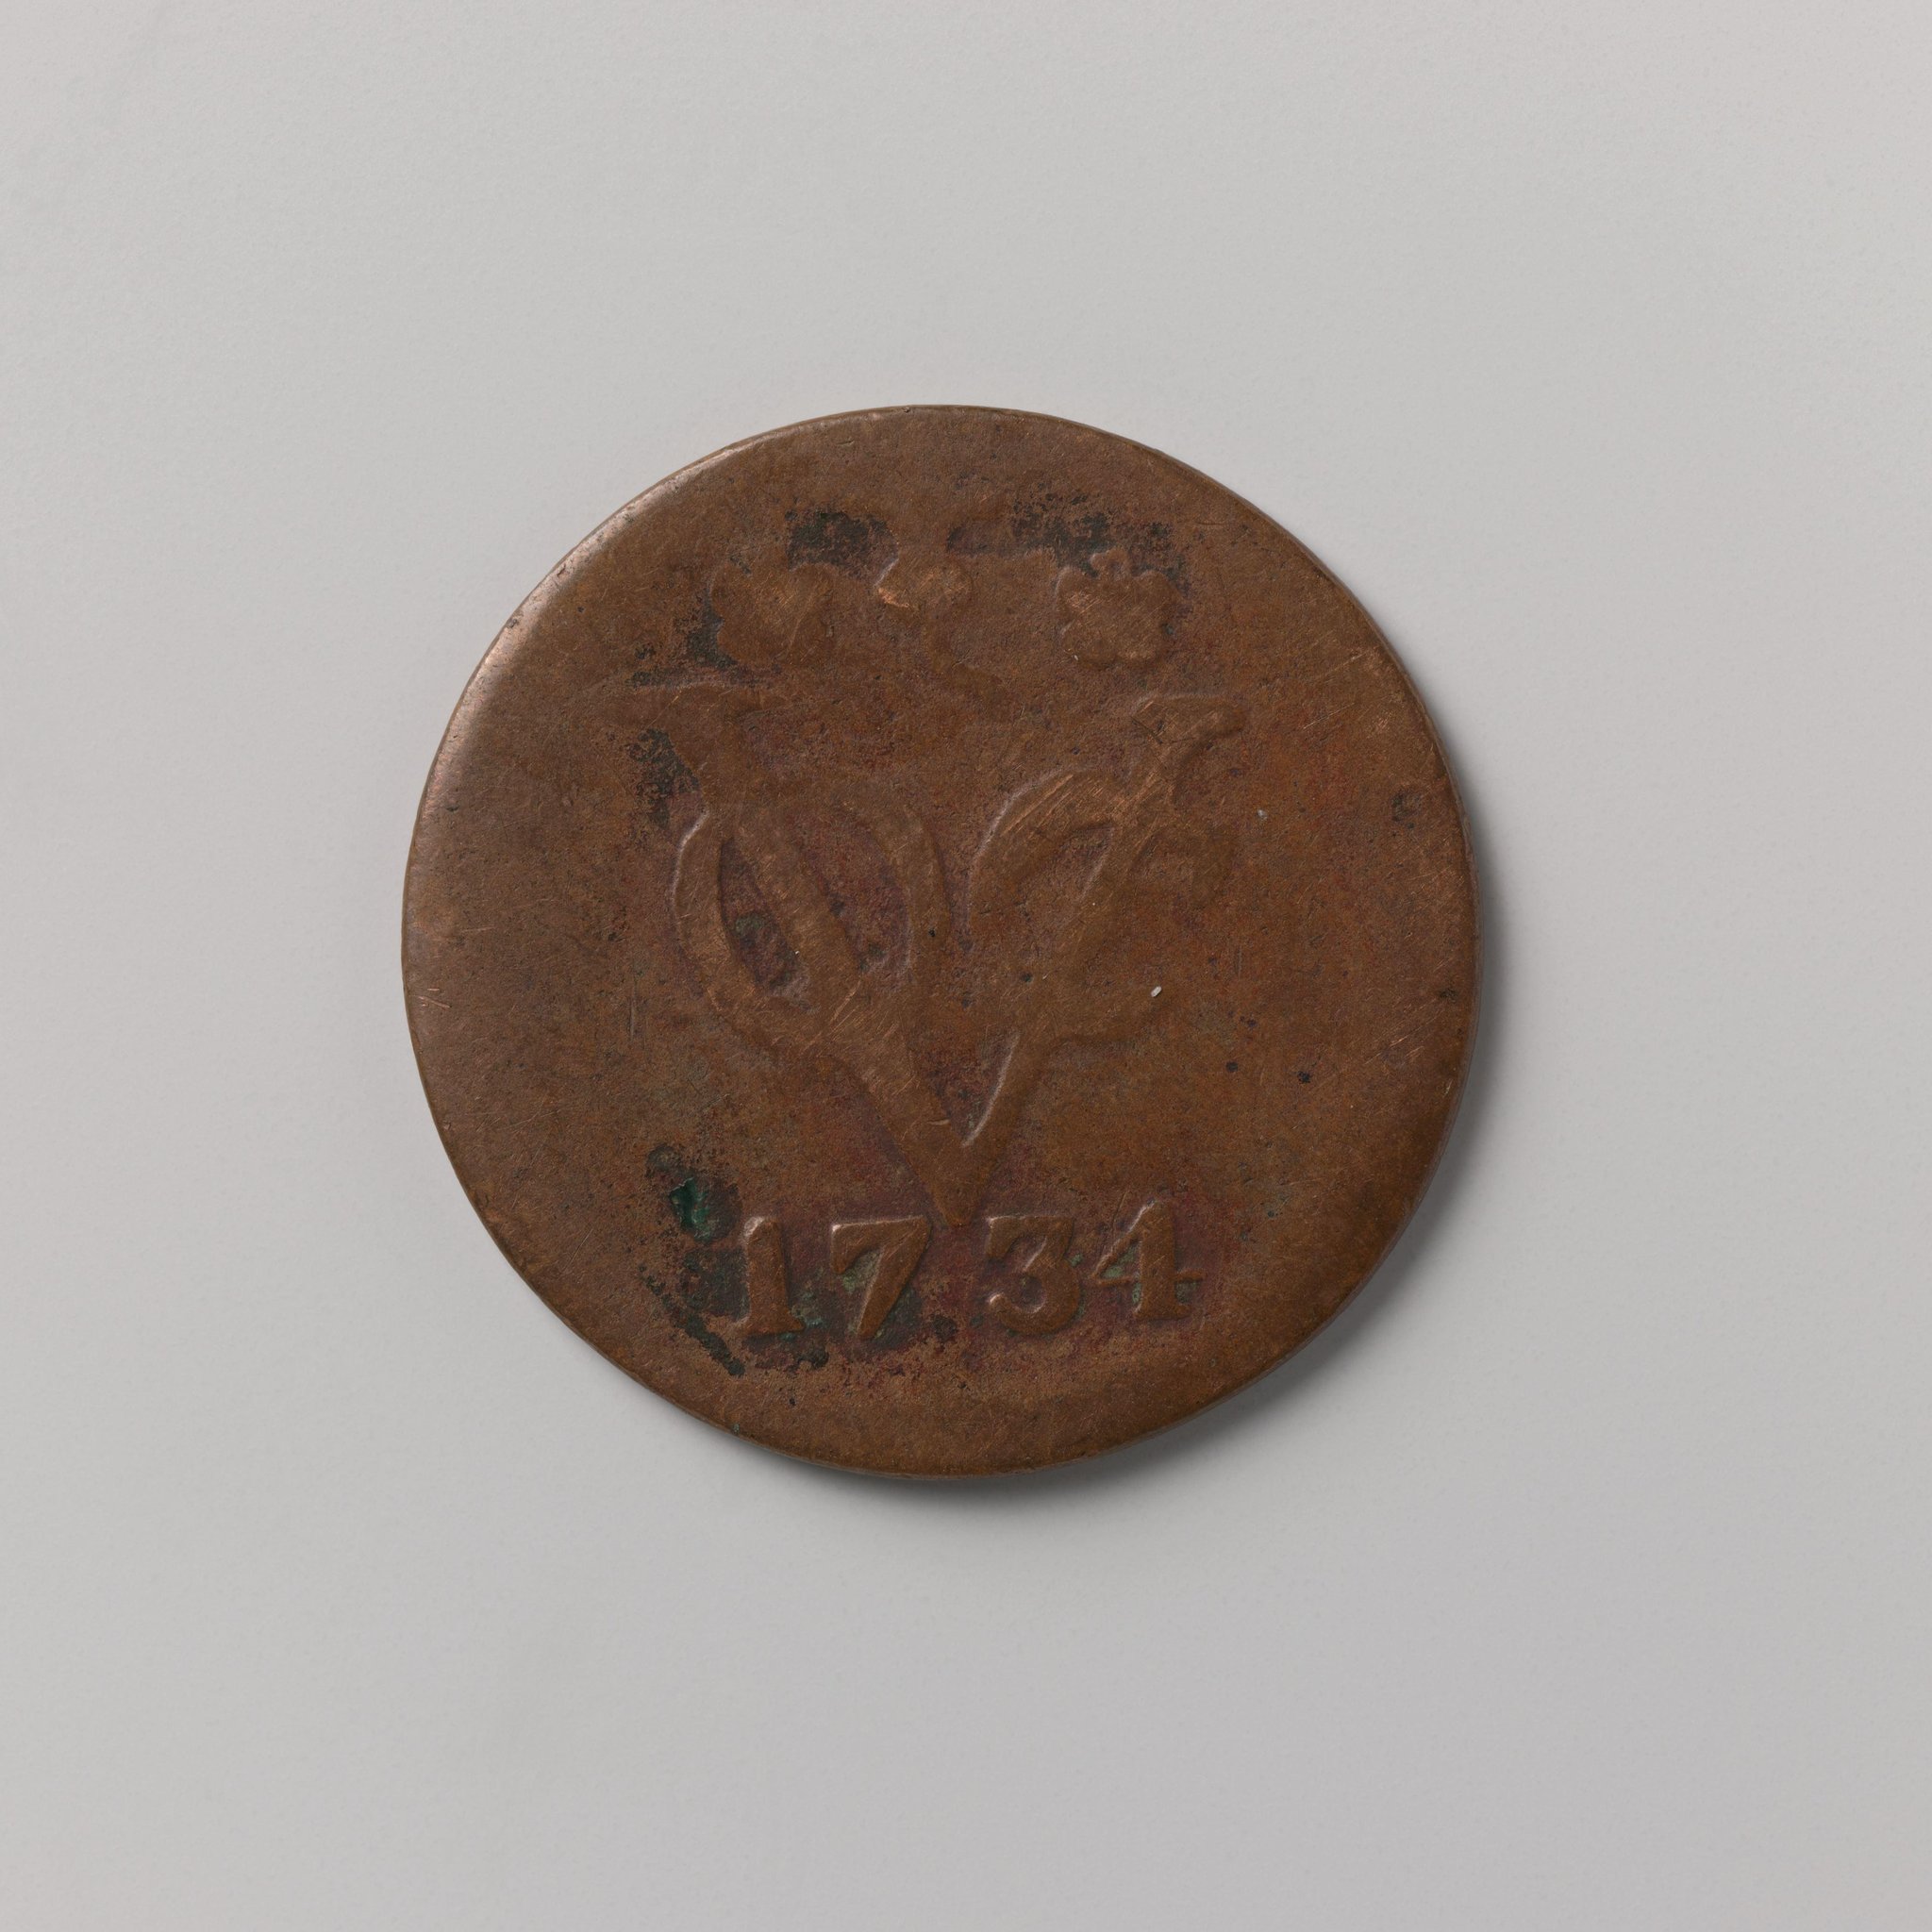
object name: coin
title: Duit van de VOC uit Westfriesland, 1734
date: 1734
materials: copper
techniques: striking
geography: enkhuizen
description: Koperen munt. Voorzijde: gekroond wapenschild van Westfriesland. Keerzijde: monogram van de VOC, waarboven muntmeesterteken en waaronder jaartal. Gladde rand.